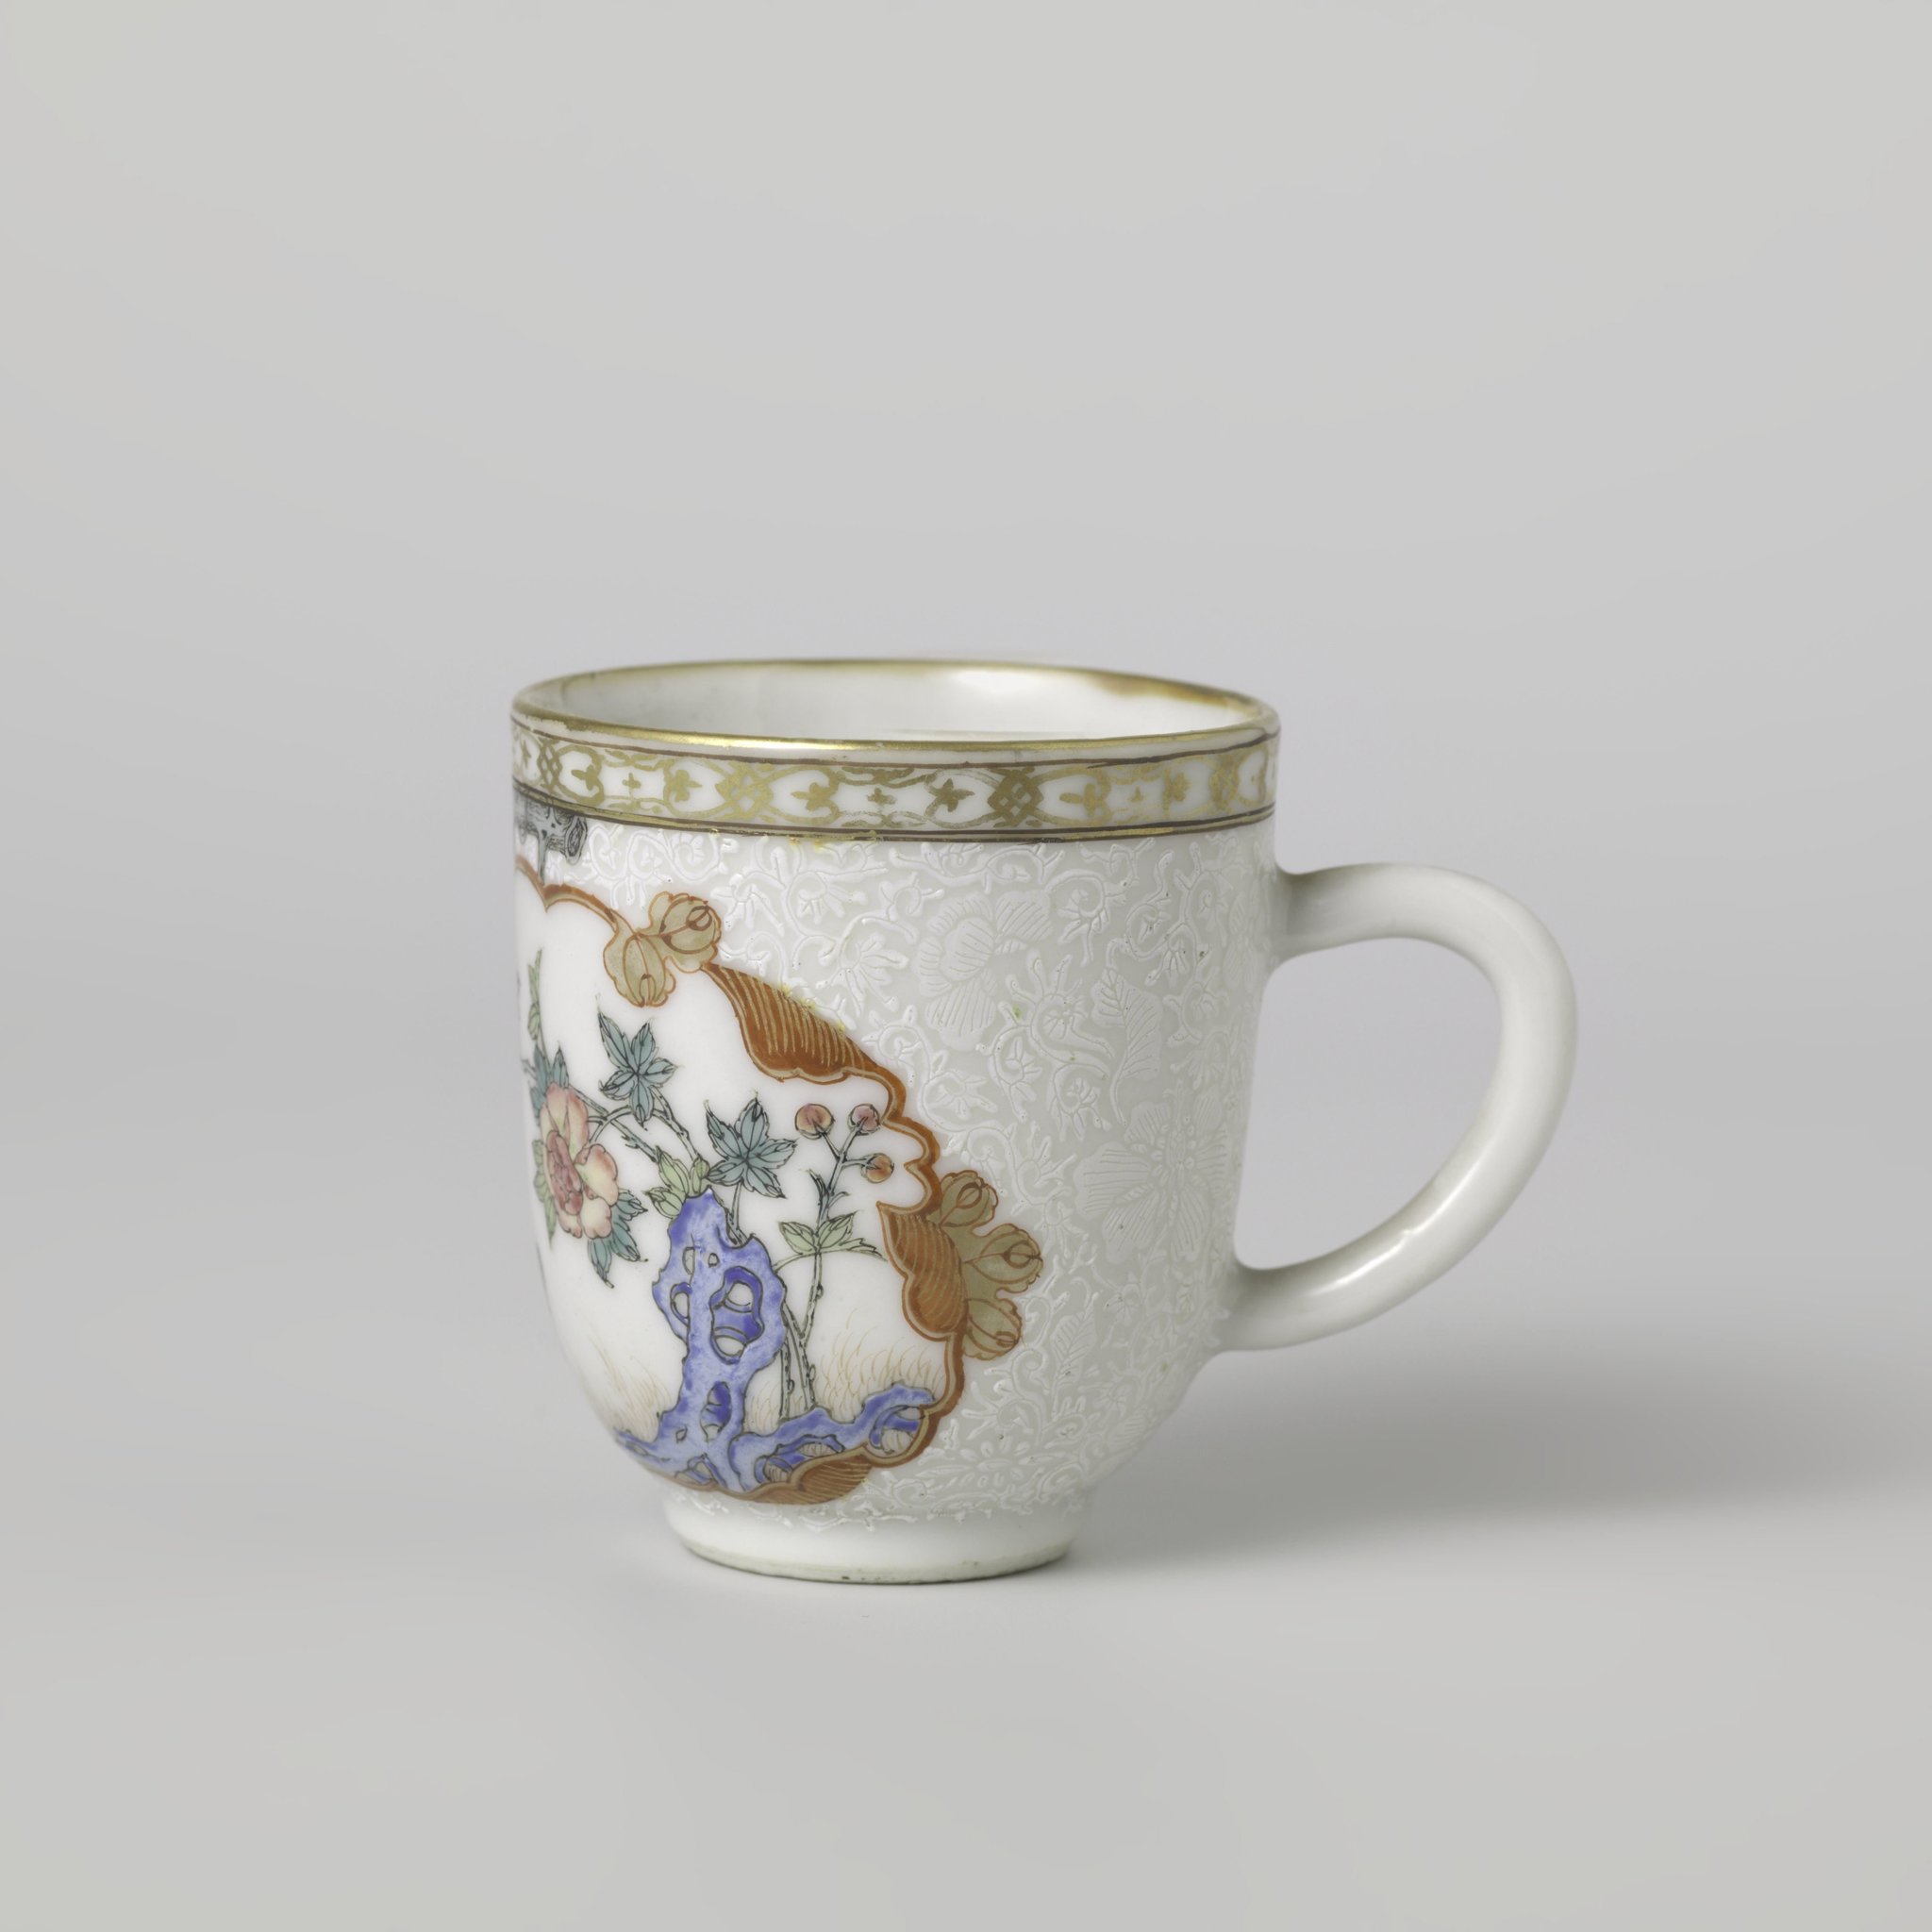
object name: oorkop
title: Cup with handle with a crane near a peony plant and rock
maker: Anonymous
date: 1725-1749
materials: glaze, gold, paint, porcelain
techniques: firing, gilding, turning, vitrification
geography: china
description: Gedecoreerd in emails, goud en bianco sopra bianco met vogels en bloeiende planten.